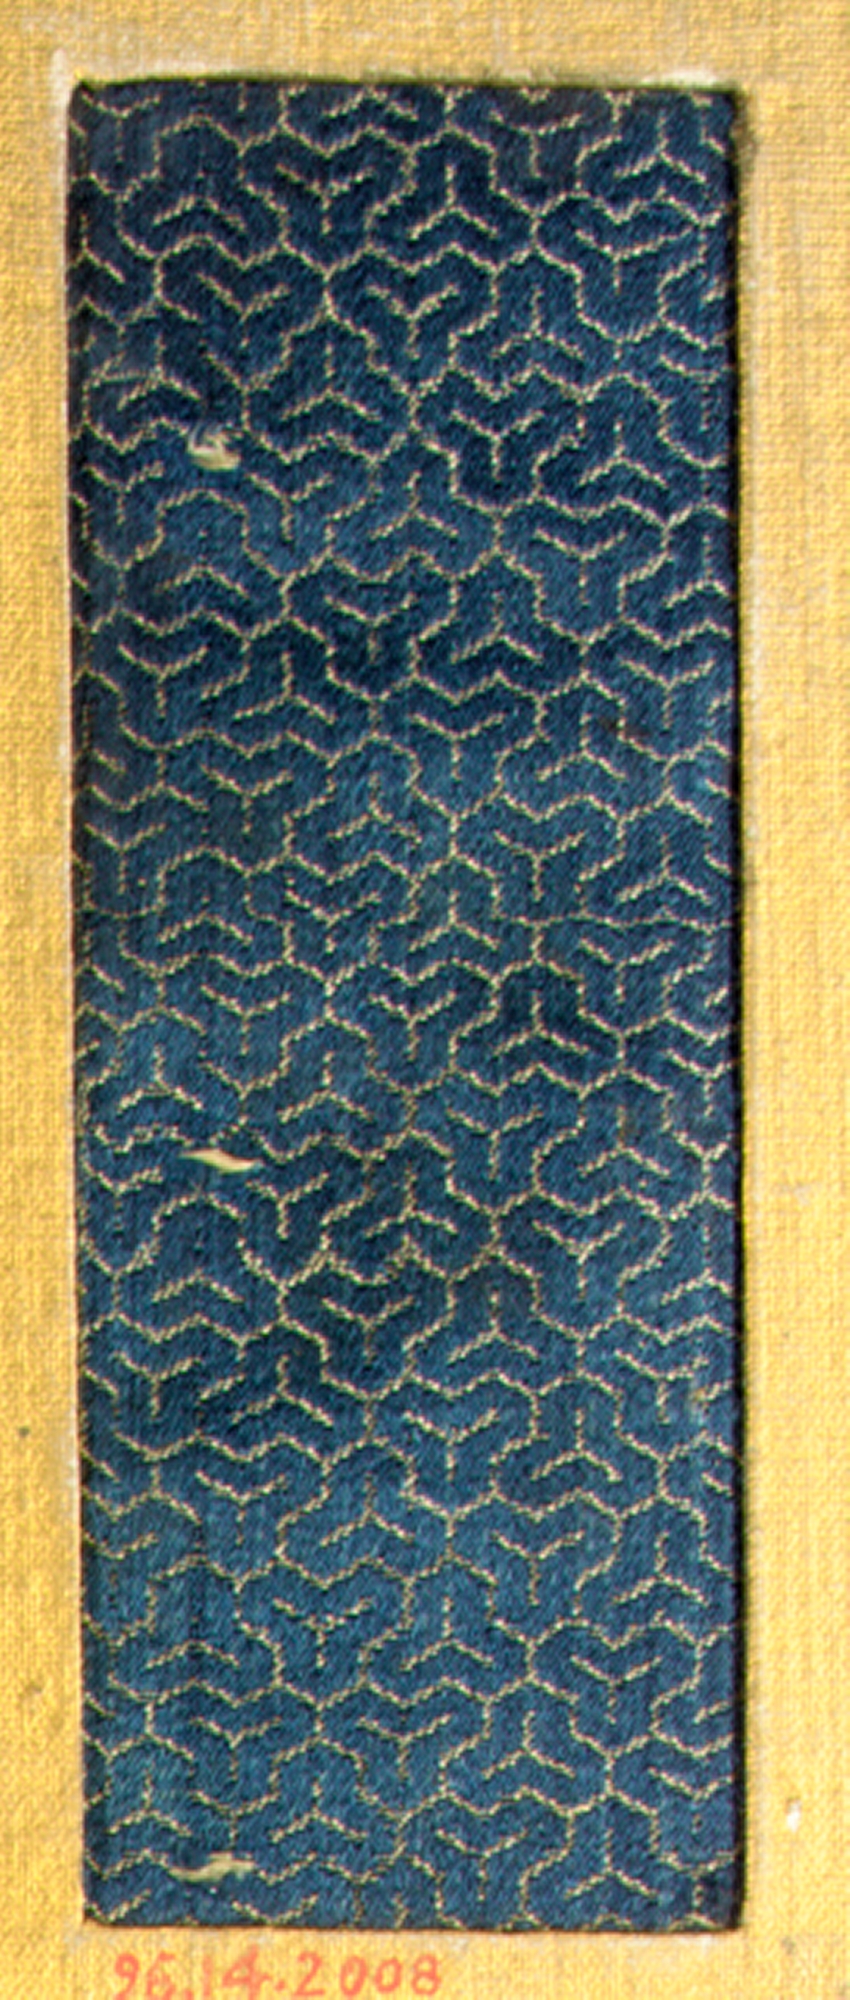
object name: piece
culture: japanese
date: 1701-1900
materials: silk